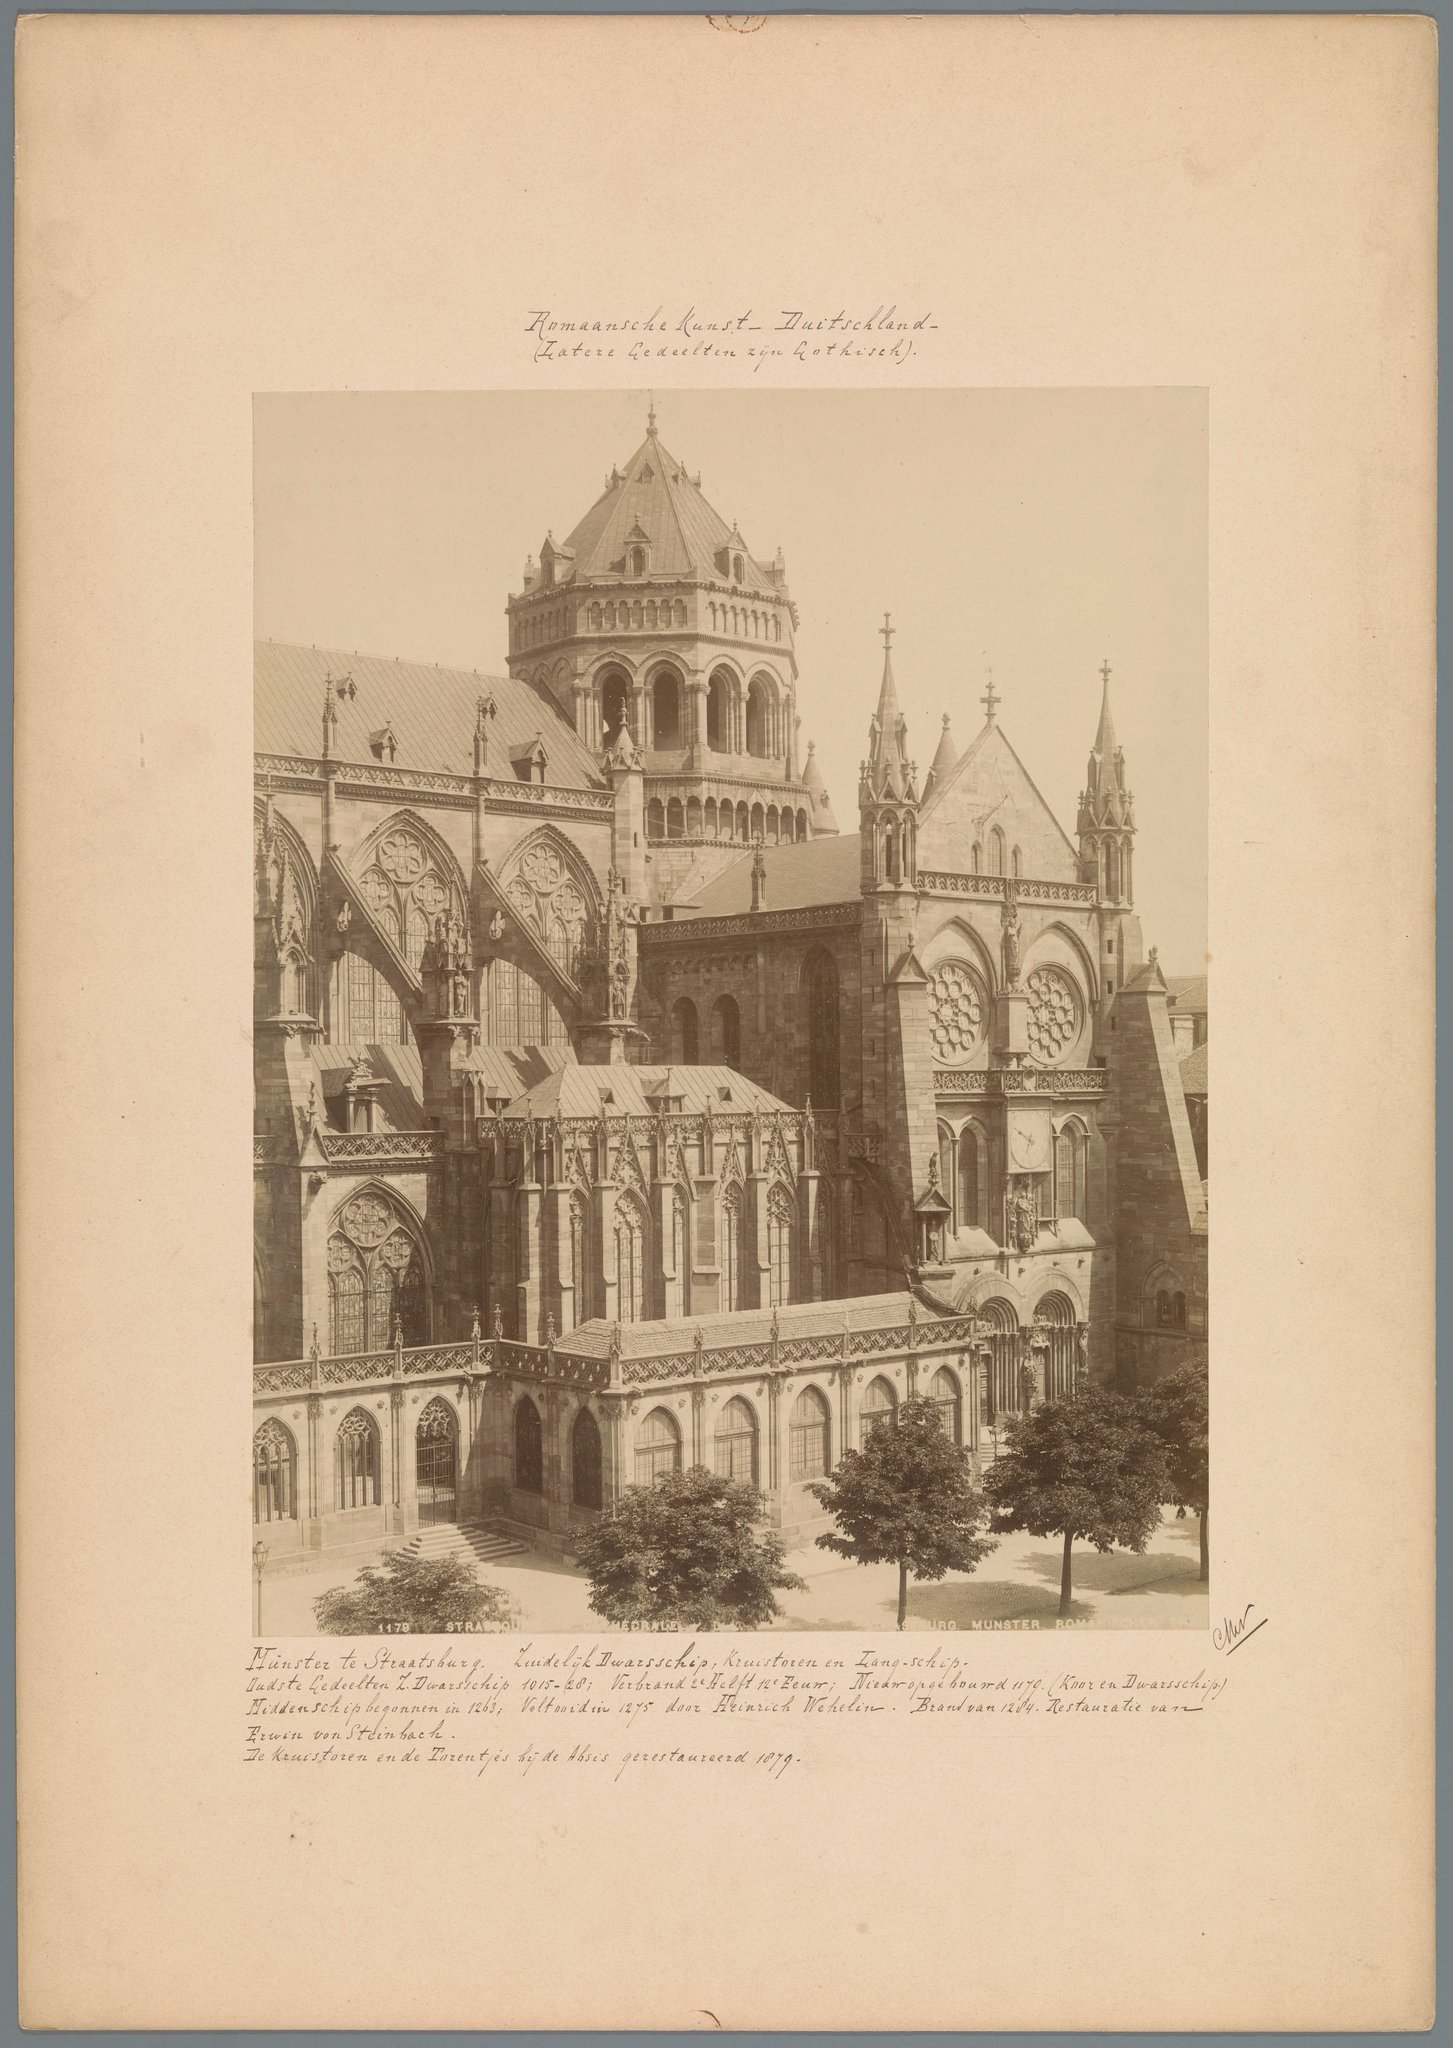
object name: photograph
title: STRASSBURG. MUNSTER ROMANISCHER [(...)]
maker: Anonymous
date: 1875-1900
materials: cardboard, photographic support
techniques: albumen print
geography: straatsburg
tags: church (exterior), façade (of house or building), parts of church exterior and annexes: tower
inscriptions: inscription: ‘CWN.’, inscription: ‘Romaansche Kunst - Duitschland. (Latere Gedeelten zijn Gothisch). Münster te Straatsburg (...) De kruistoren en de Torentjes bij de Absis gerestaureerd 1879.’, collector's mark: ‘INSTITUUT VOOR KUNST- NIJVERHEIDSONDERWIJS GABRIËL METSUSTRAAT No. 16. AMSTERDAM’, number: ‘1179’, collector's mark: ‘KUNSTNIJVERHEIDSCHOOL QUELLINUS AMSTERDAM FRANS HALSSTRAAT 14.’